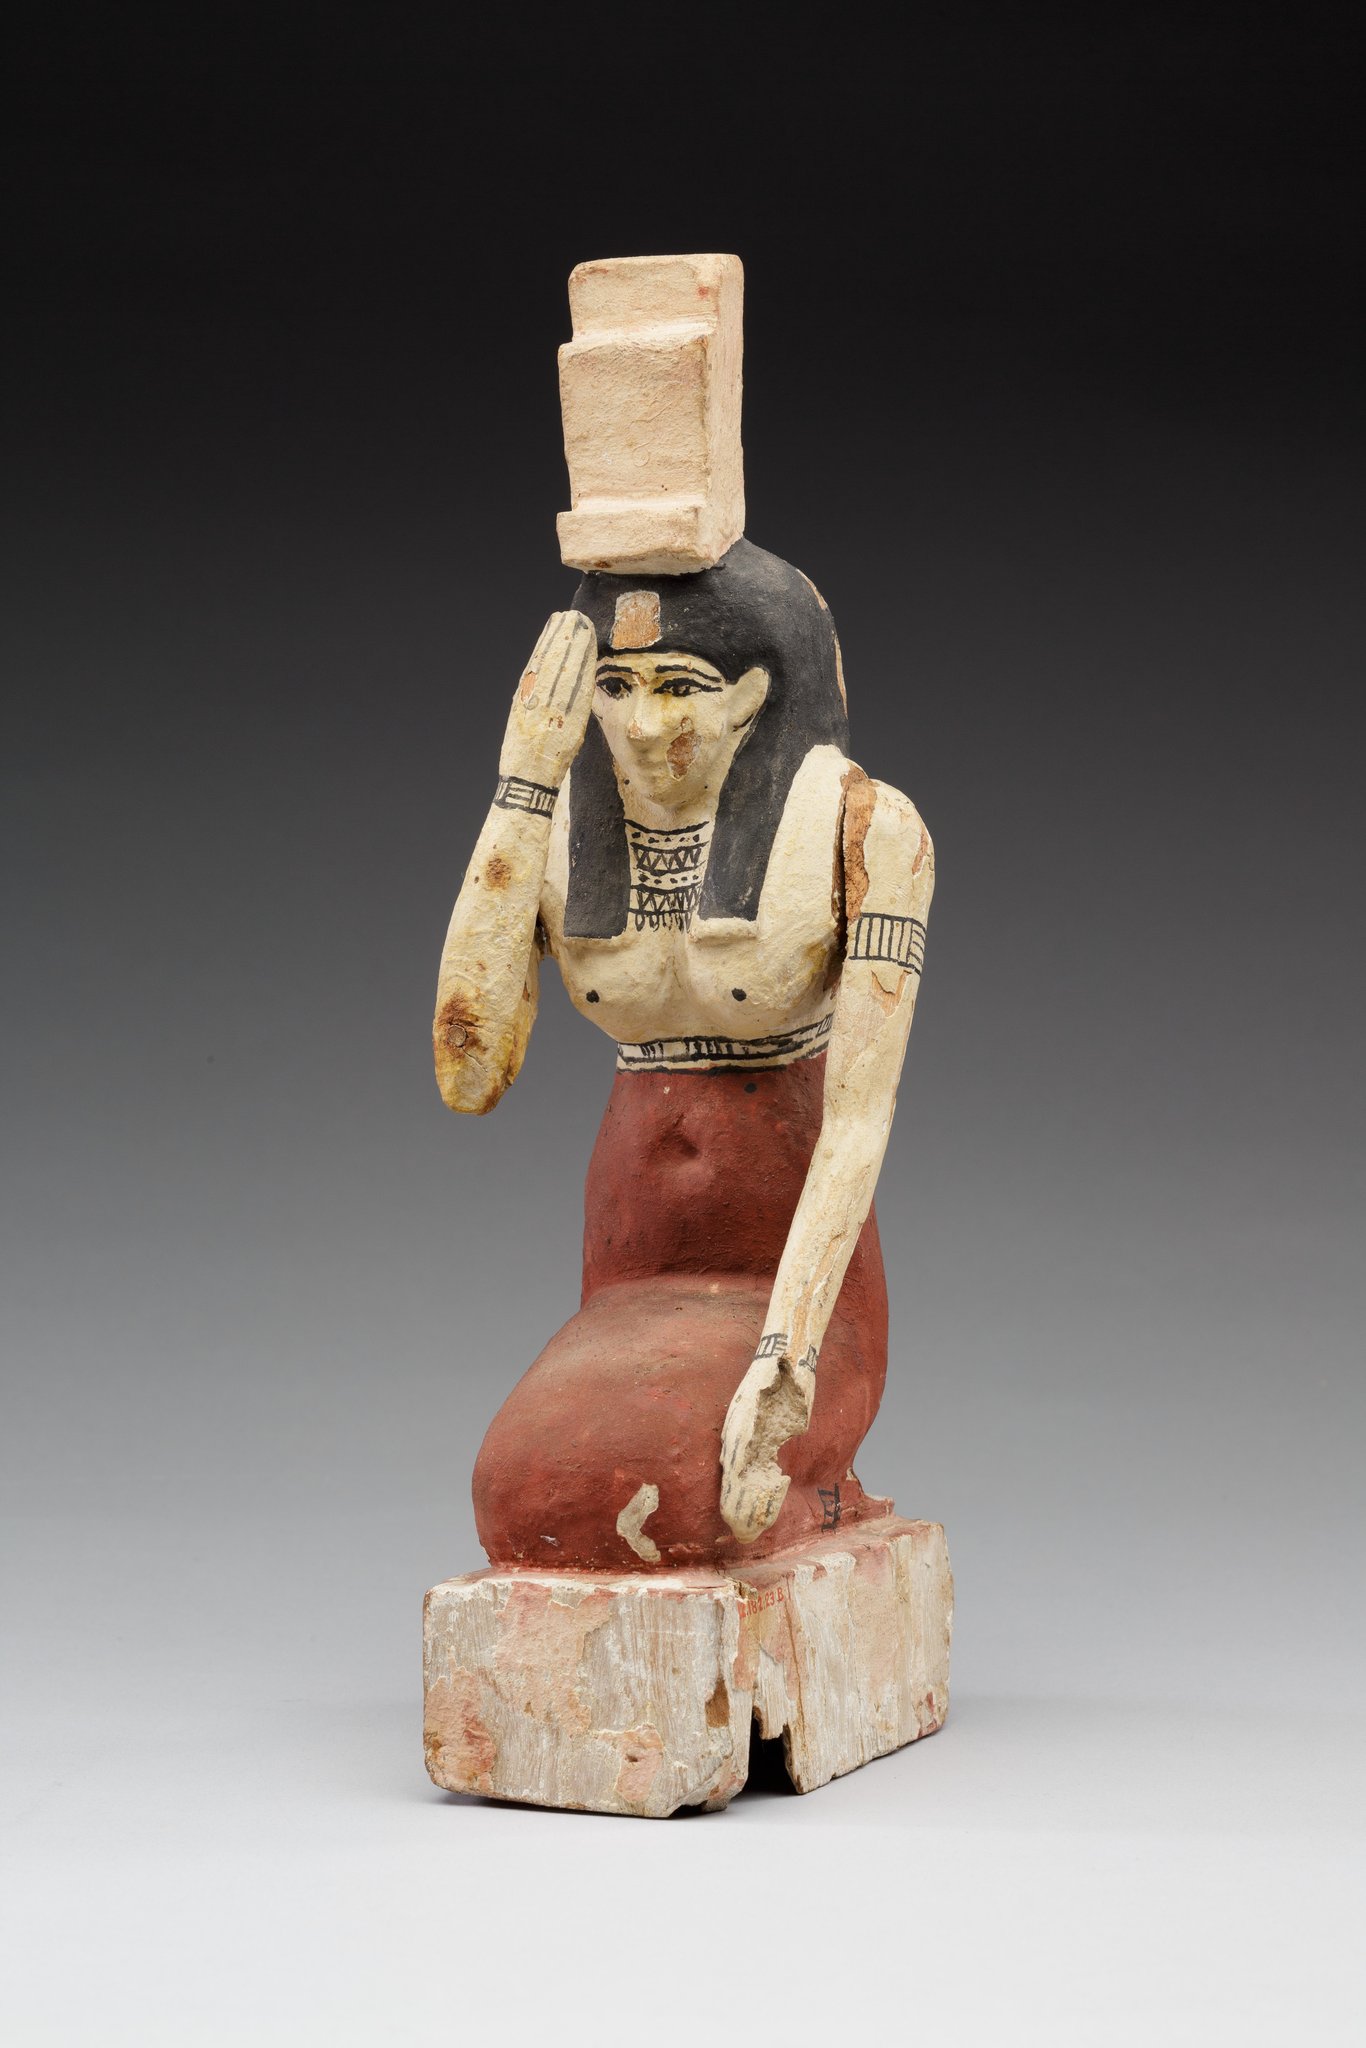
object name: statuette, isi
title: Mourning Isis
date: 332-330 BCE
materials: paint, paste, wood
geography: egypt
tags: isis,goddess